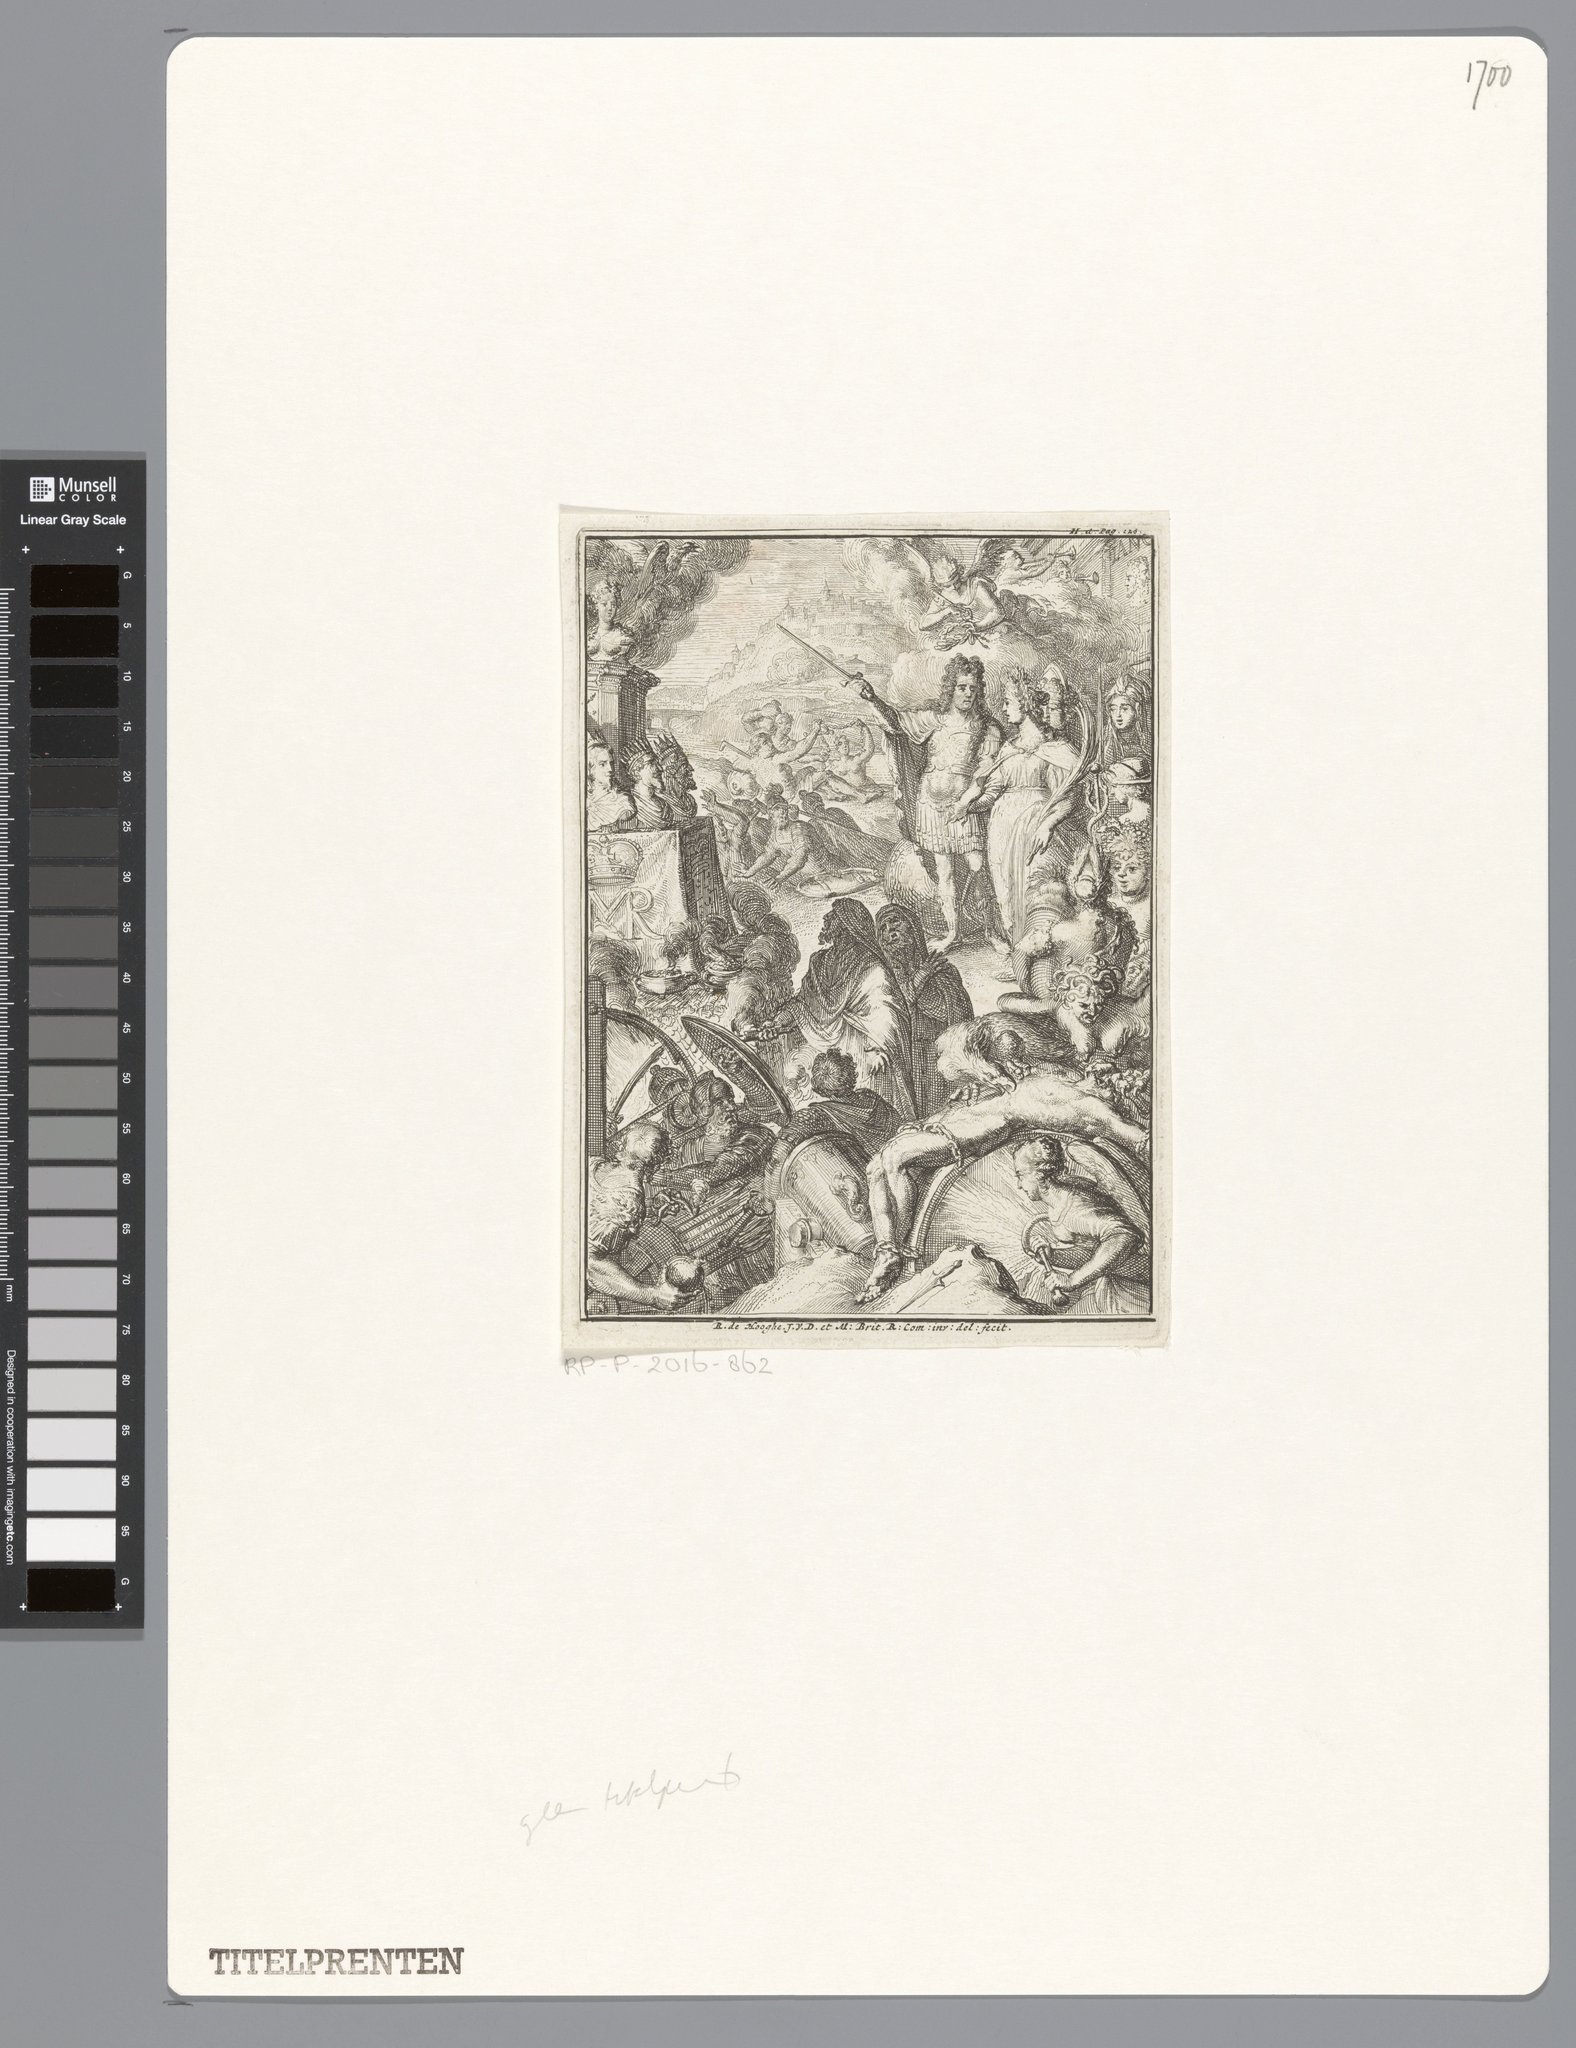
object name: print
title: Stadhouder Willem III en Maria Stuart te midden van mythische figuren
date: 1700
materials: paper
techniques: etching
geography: haarlem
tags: the hague, william iii (prince of orange and king of england, scotland, and ireland), london, maria ii stuart (koningin van engeland, schotland en ierland), (story of) ceres (demeter), (story of) bacchus (dionysus), liber, (story of) mercury (hermes), an eagle tears at prometheus' liver, invidia (envy) as roman personification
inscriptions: collector's mark: Lugt 2228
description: Stadhouder Willem III en zijn vrouw Maria Stuart staan hand in hand te midden van mythische figuren, zoals Prometheus (geketend op de voorgrond), de Afgunst (met slangenhaar), Ceres (met hoorn des overvloeds), Bacchus (met druivenranken) en Mercurius (met caduceus). Links onderin soldaten bij een kanon. Rechts boven H. d. Pag. 128.